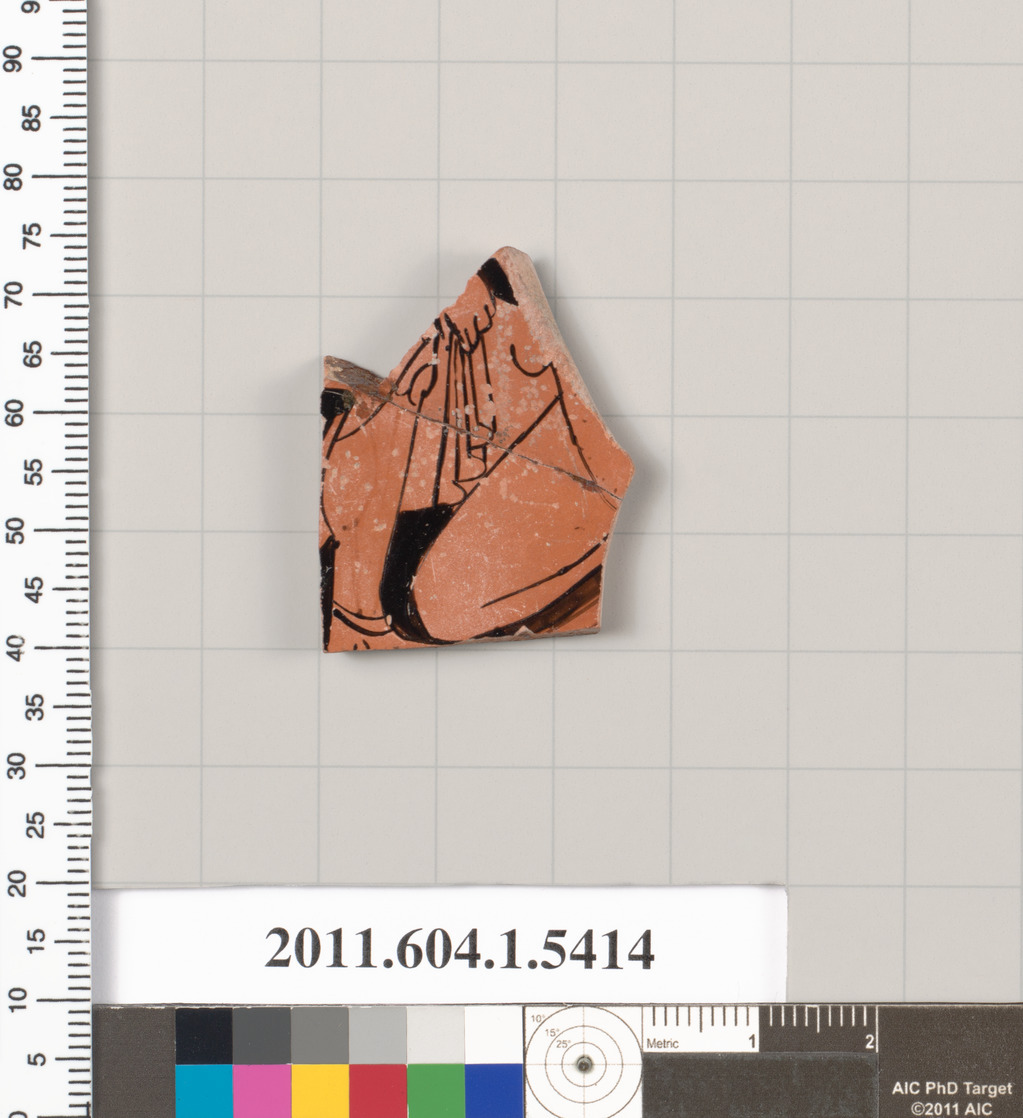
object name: kylix fragment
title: Terracotta fragment of a kylix (drinking cup)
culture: greek, attic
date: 500-480 BCE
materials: terracotta